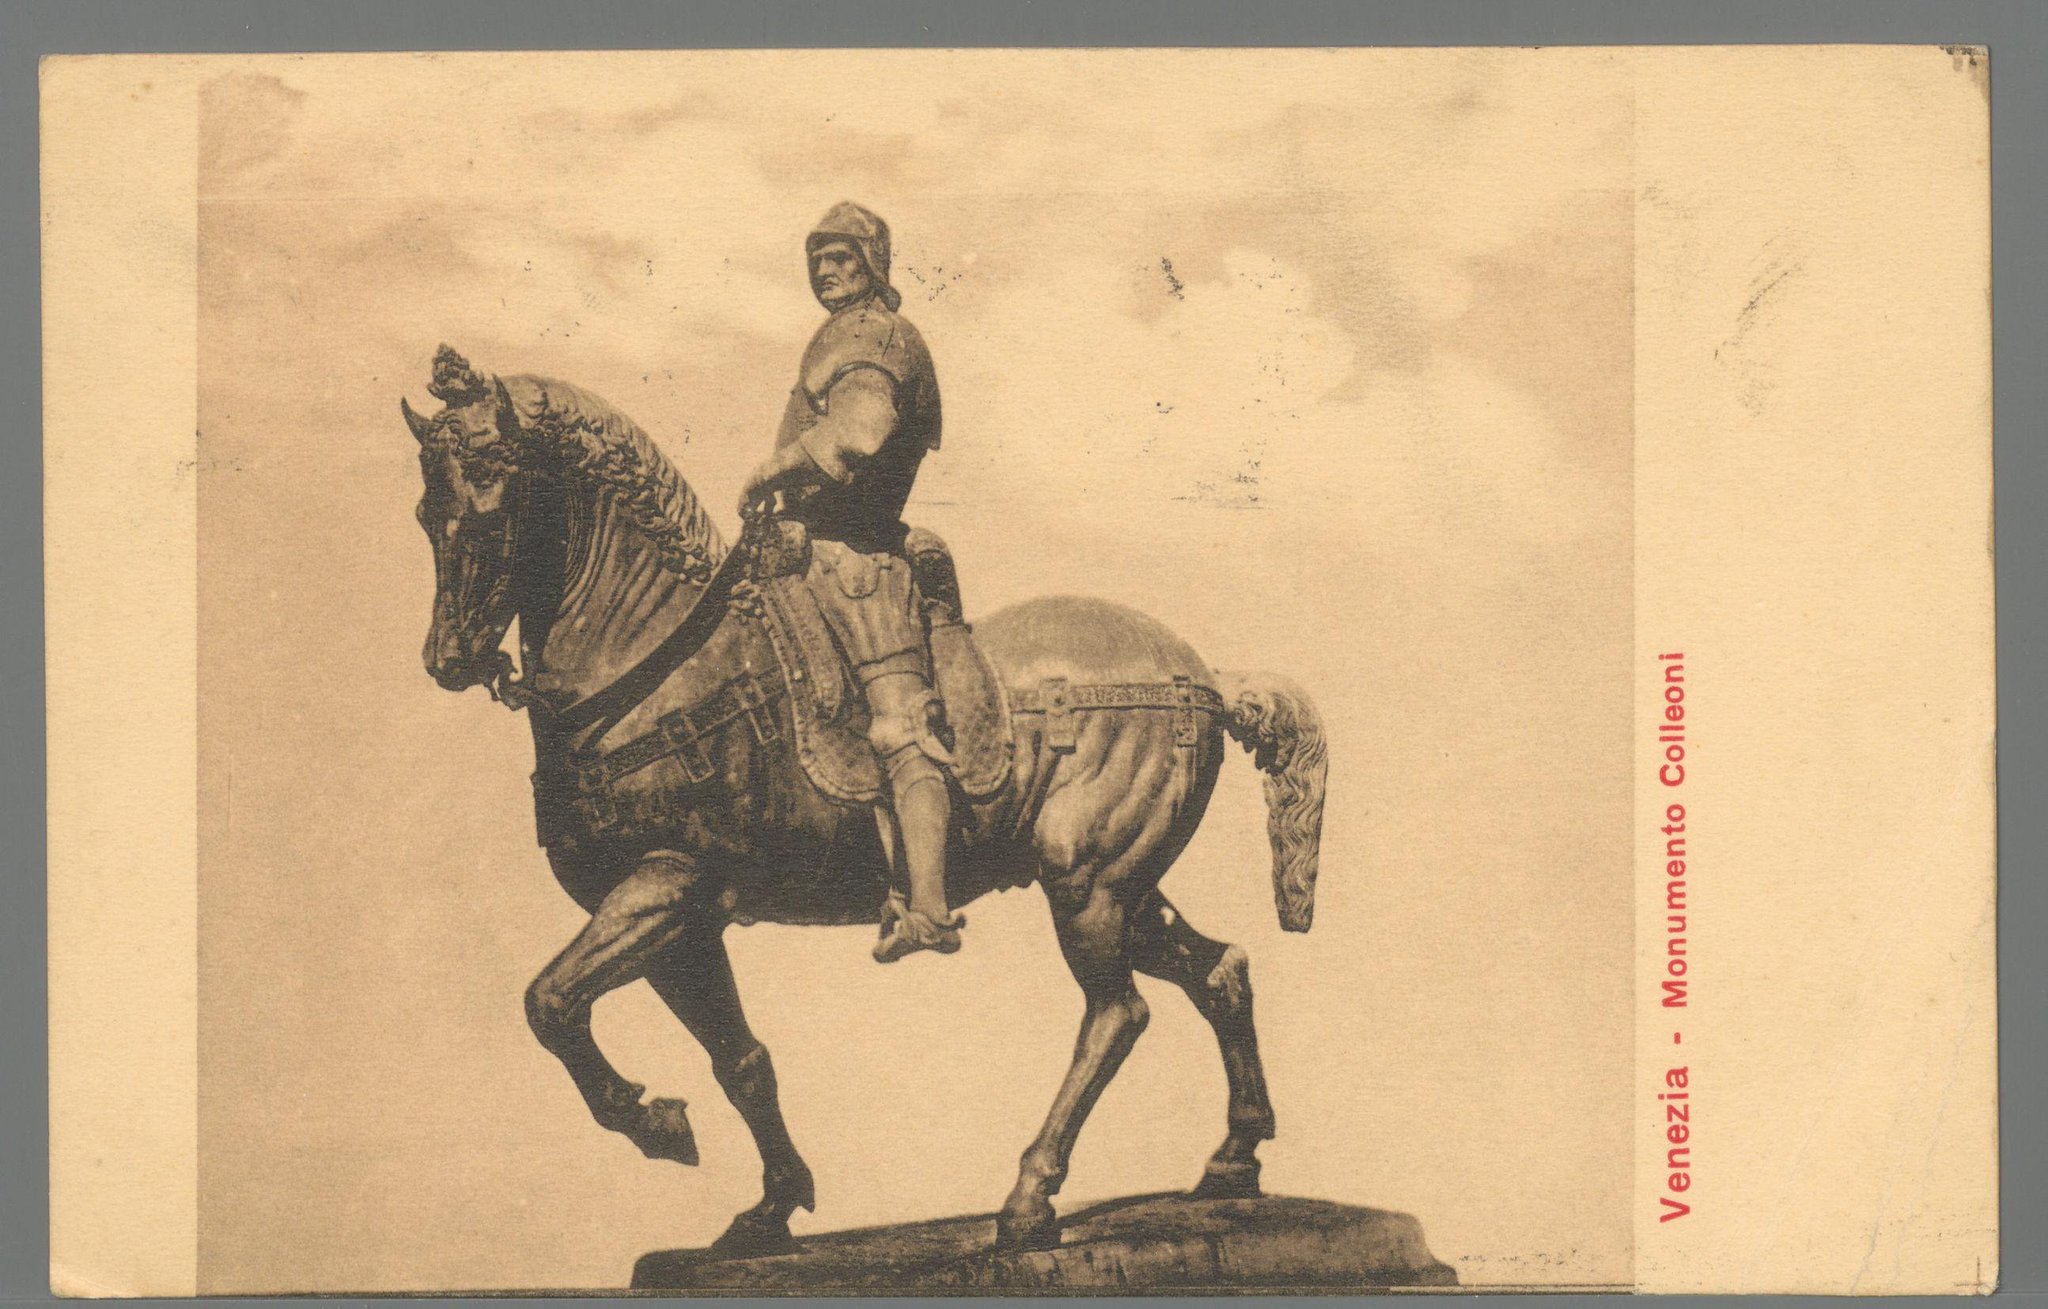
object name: ansichtkaart, prentbriefkaart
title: Venezia. Monumento Colleoni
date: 1906-1921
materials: cardboard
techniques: photograph, writing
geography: venice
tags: monument, statue, venice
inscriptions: postage stamp